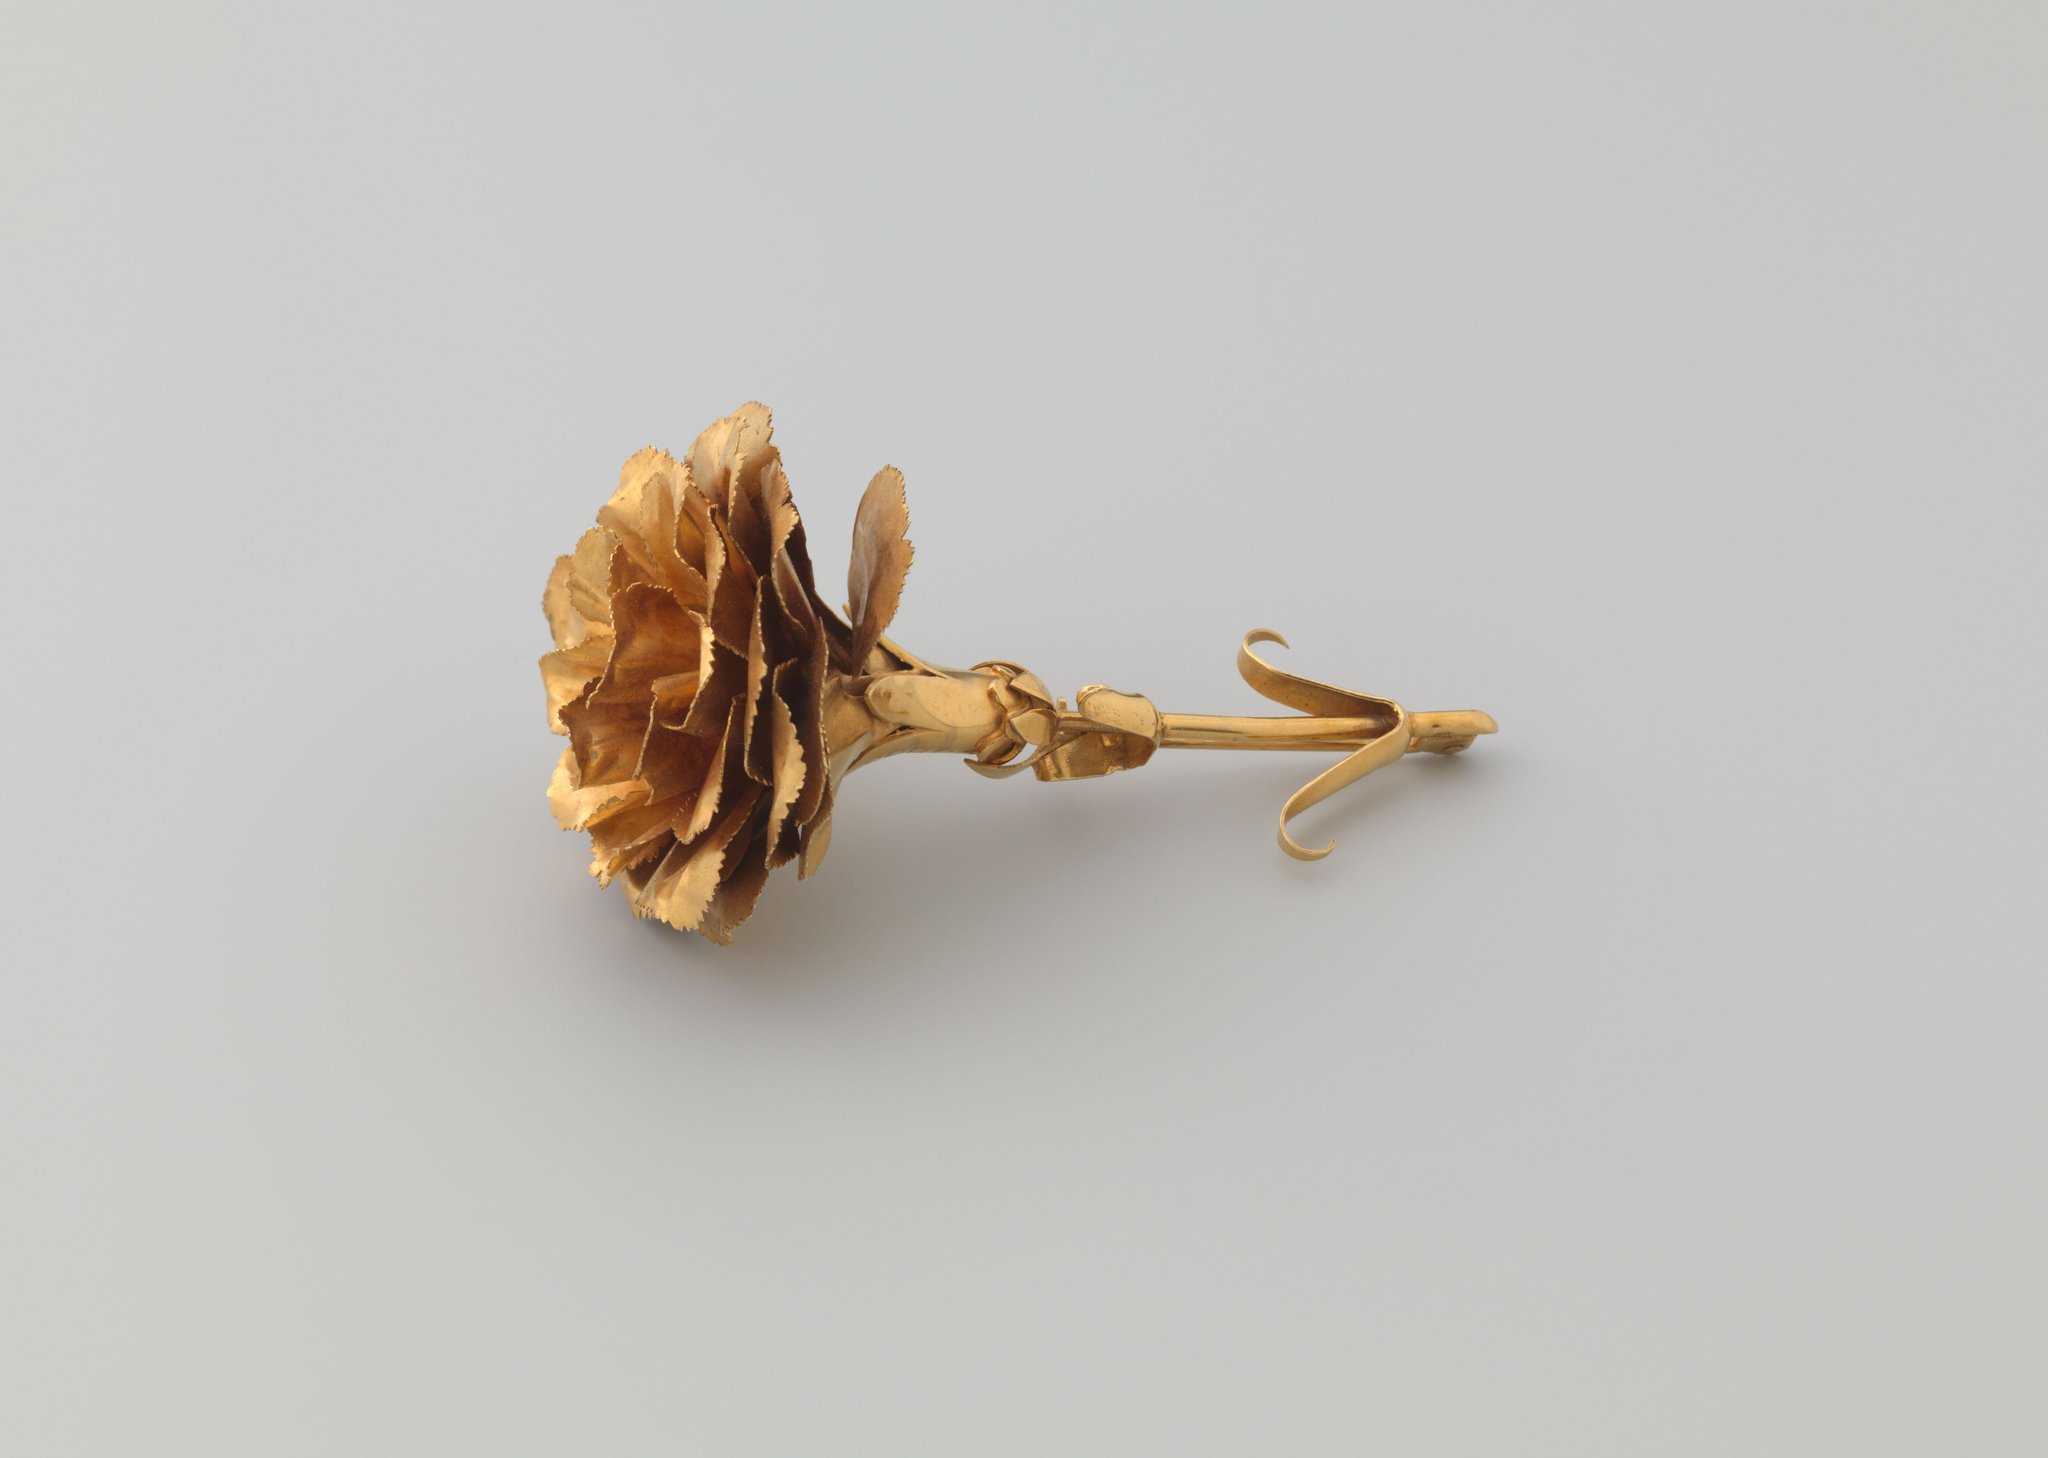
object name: brooch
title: Broche van goud, 'Anjer'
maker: n. bink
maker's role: juwelier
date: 1967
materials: gold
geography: leiden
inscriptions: inscription: ‘SRBC’, date: ‘1967’, alloy mark, maker's mark: ‘N B’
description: Gouden broche 'Anjer' voorzien van een kogelsluiting. Waarschijnlijk is de broche gemaakt voor een speciale gelegenheid; het jaartal 1967 is duidelijk leesbaar in de knop van de bloem opgenomen. In foedraal.